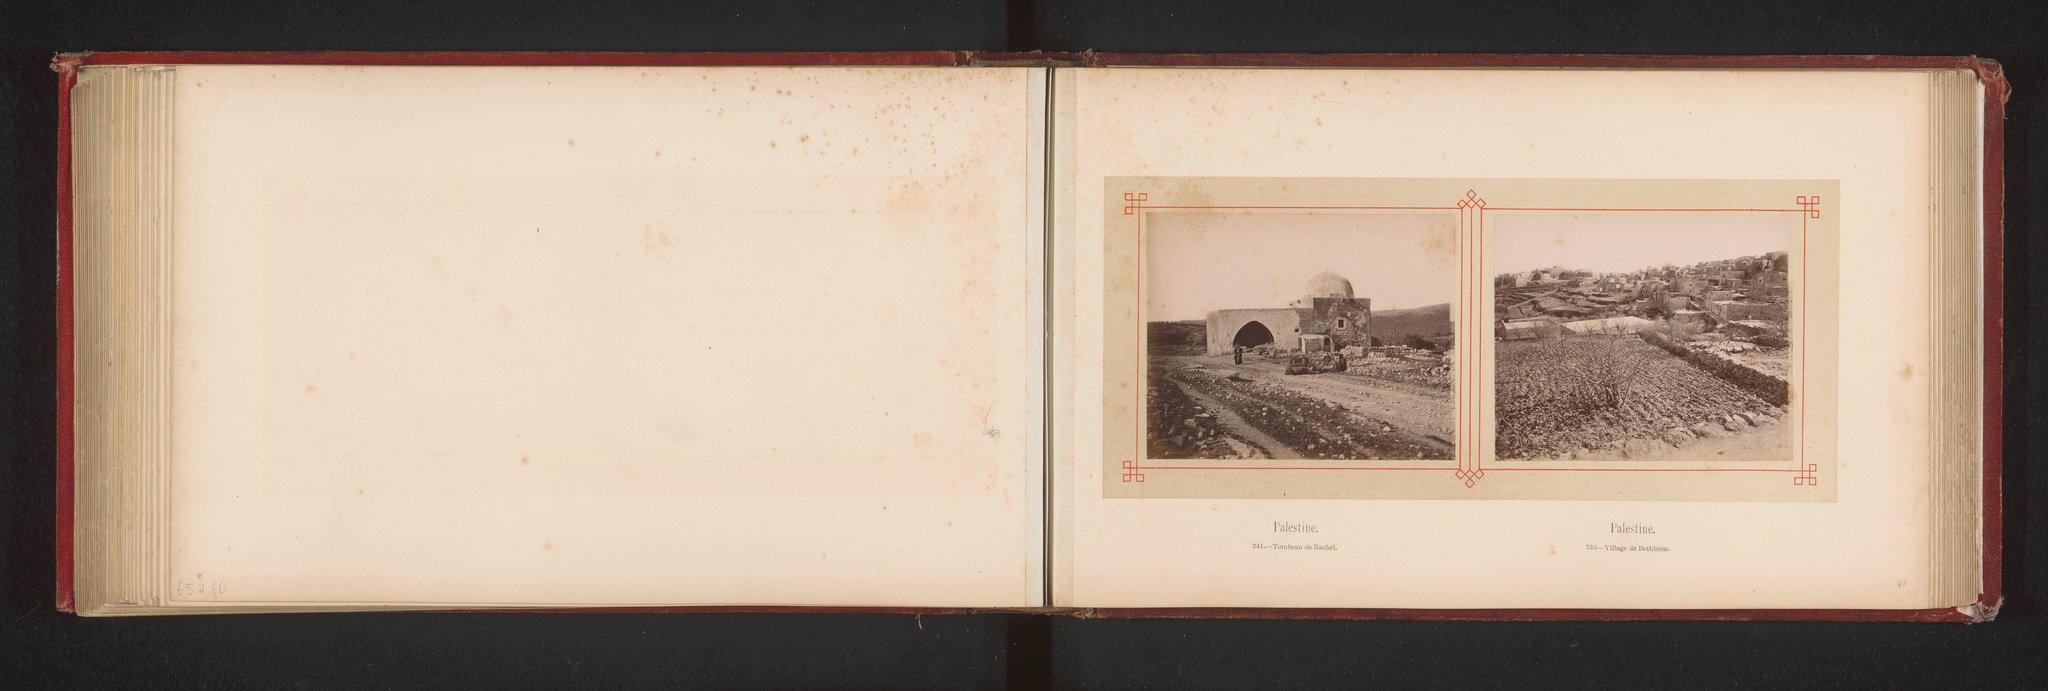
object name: page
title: Gezicht op Bethlehem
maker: félix bonfils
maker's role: fotograaf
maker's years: 1831-1885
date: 1873-1878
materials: photographic support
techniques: albumen print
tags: city-view in general; 'veduta'